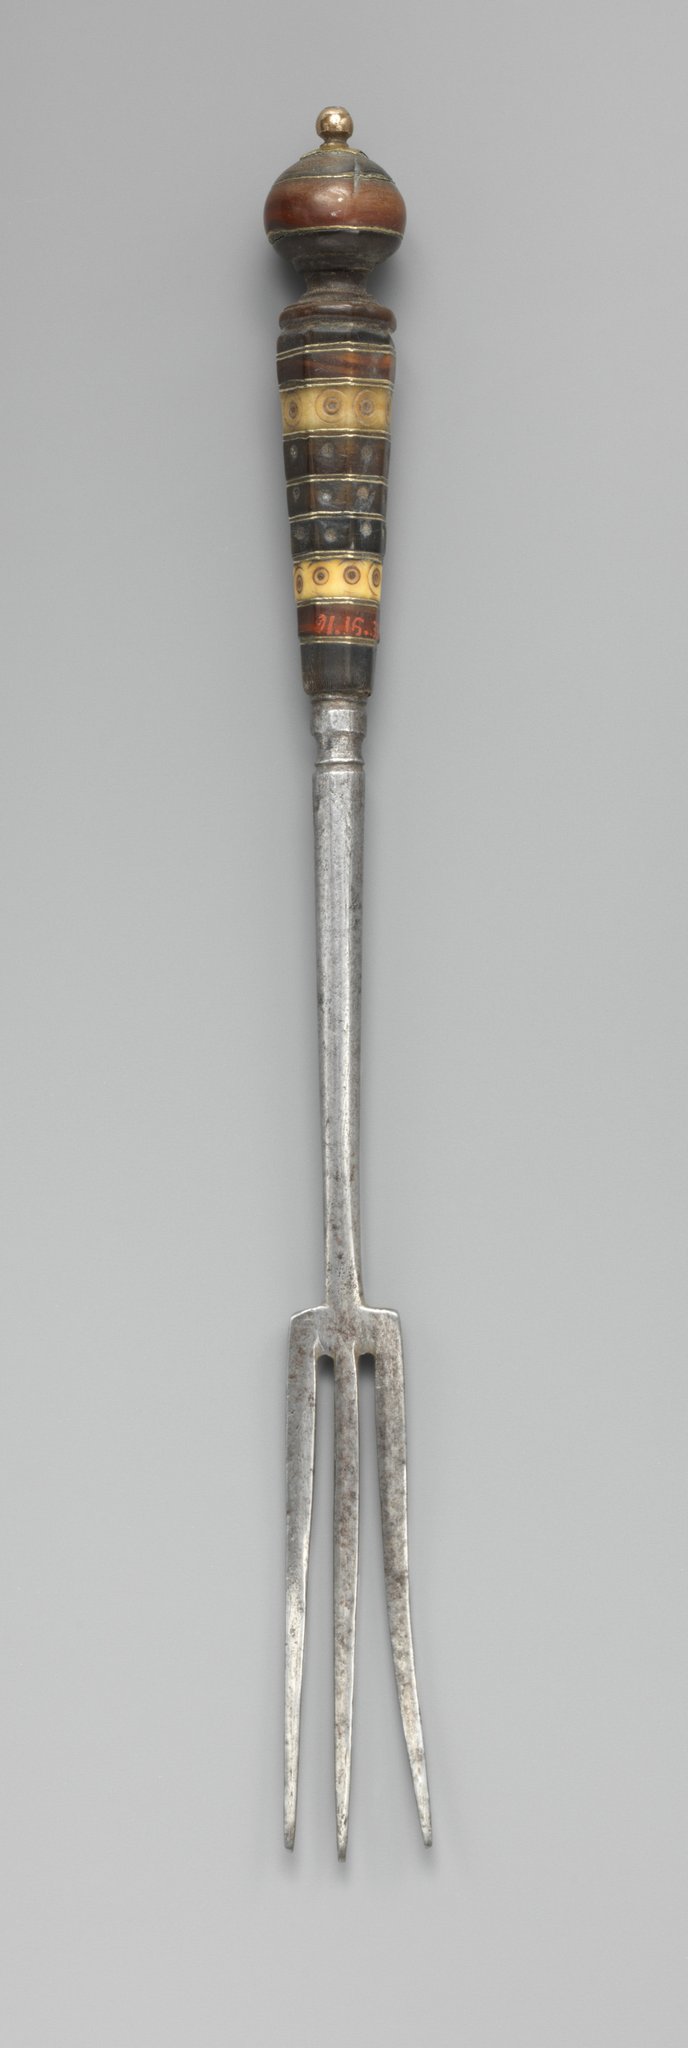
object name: table fork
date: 1601-1700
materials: bone, metal, steel